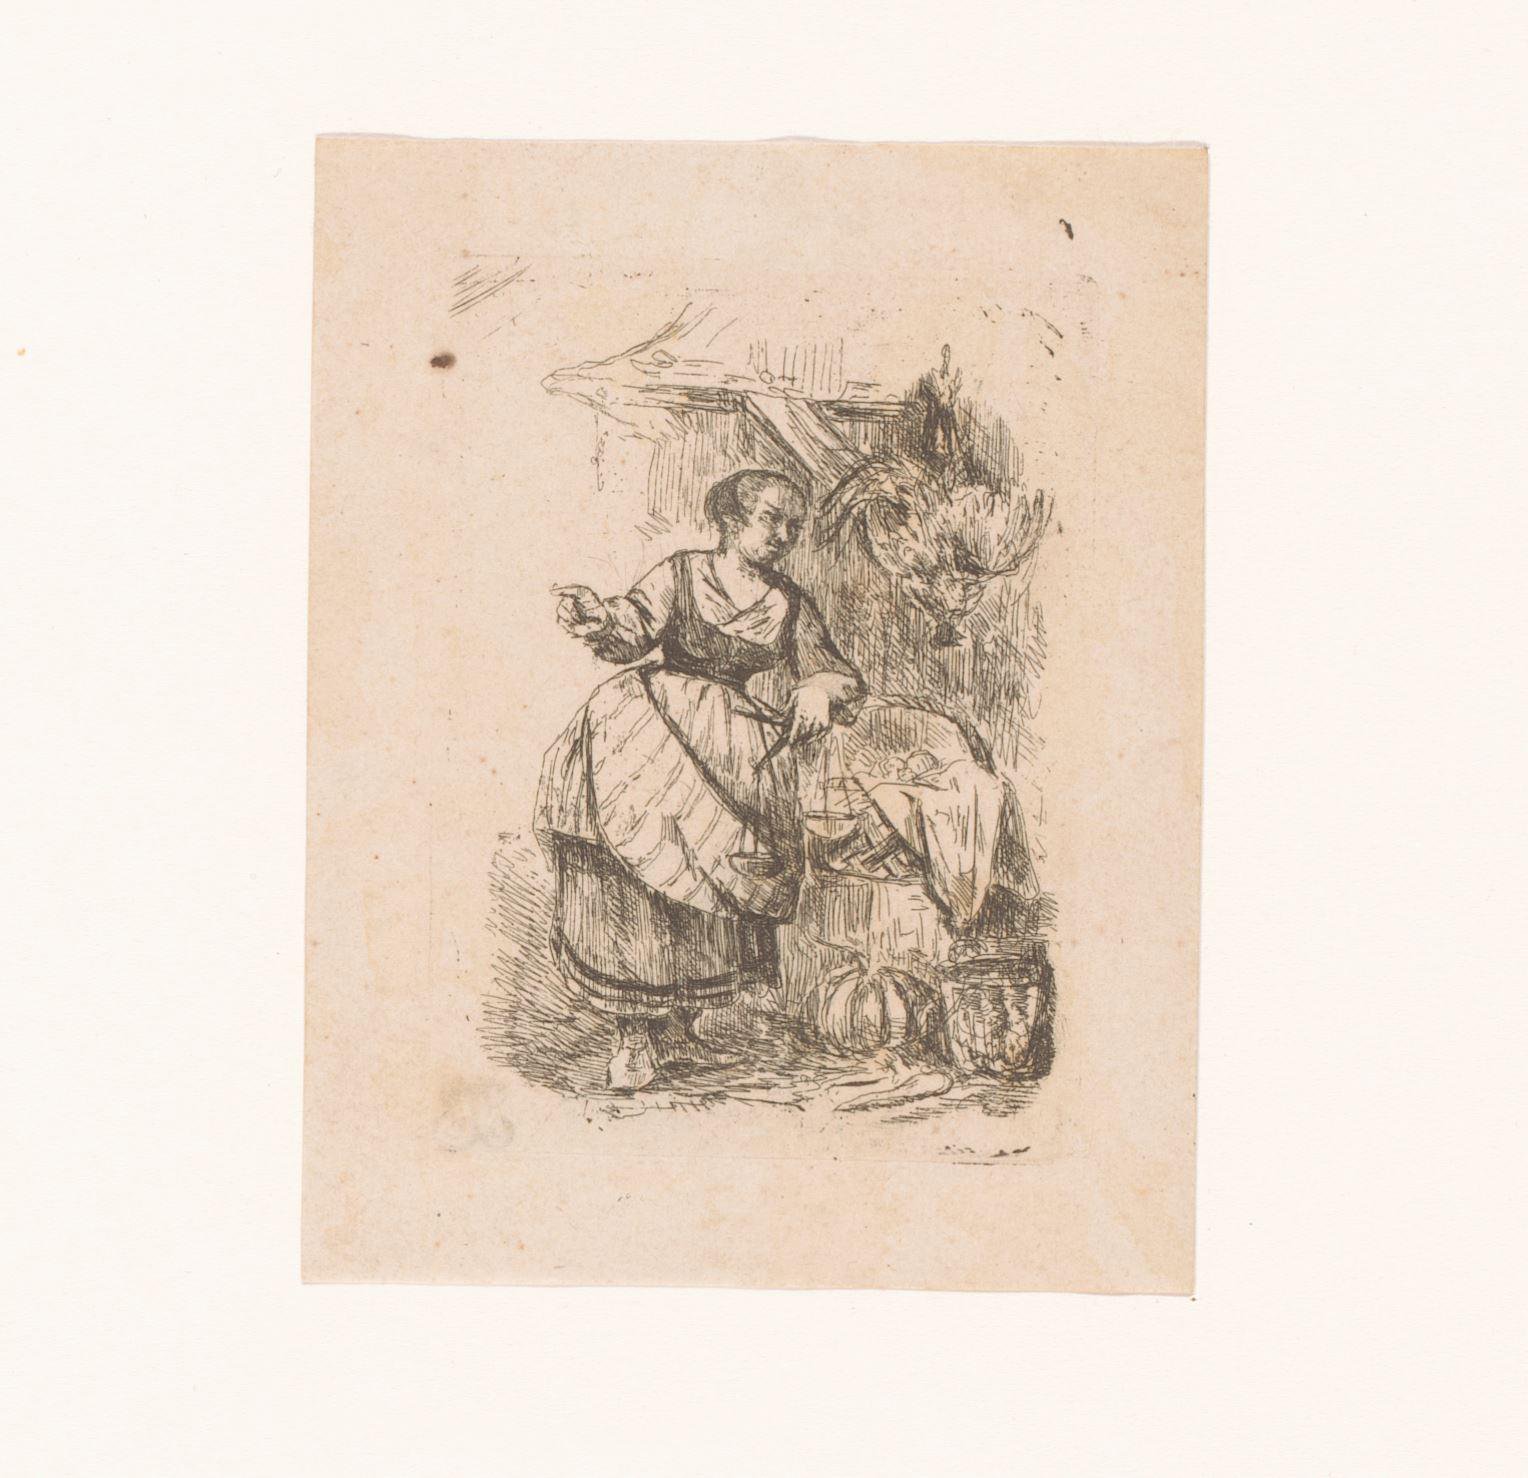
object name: print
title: Koopvrouw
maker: adrien joseph verhoeven-ball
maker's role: draughtsman, print maker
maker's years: 1824-1882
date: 1834-1882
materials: paper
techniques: drypoint, etching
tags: merchant, salesman - bb - women engaged in trade and commerce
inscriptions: collector's mark: Lugt 2228, collector's mark: Lugt 1485